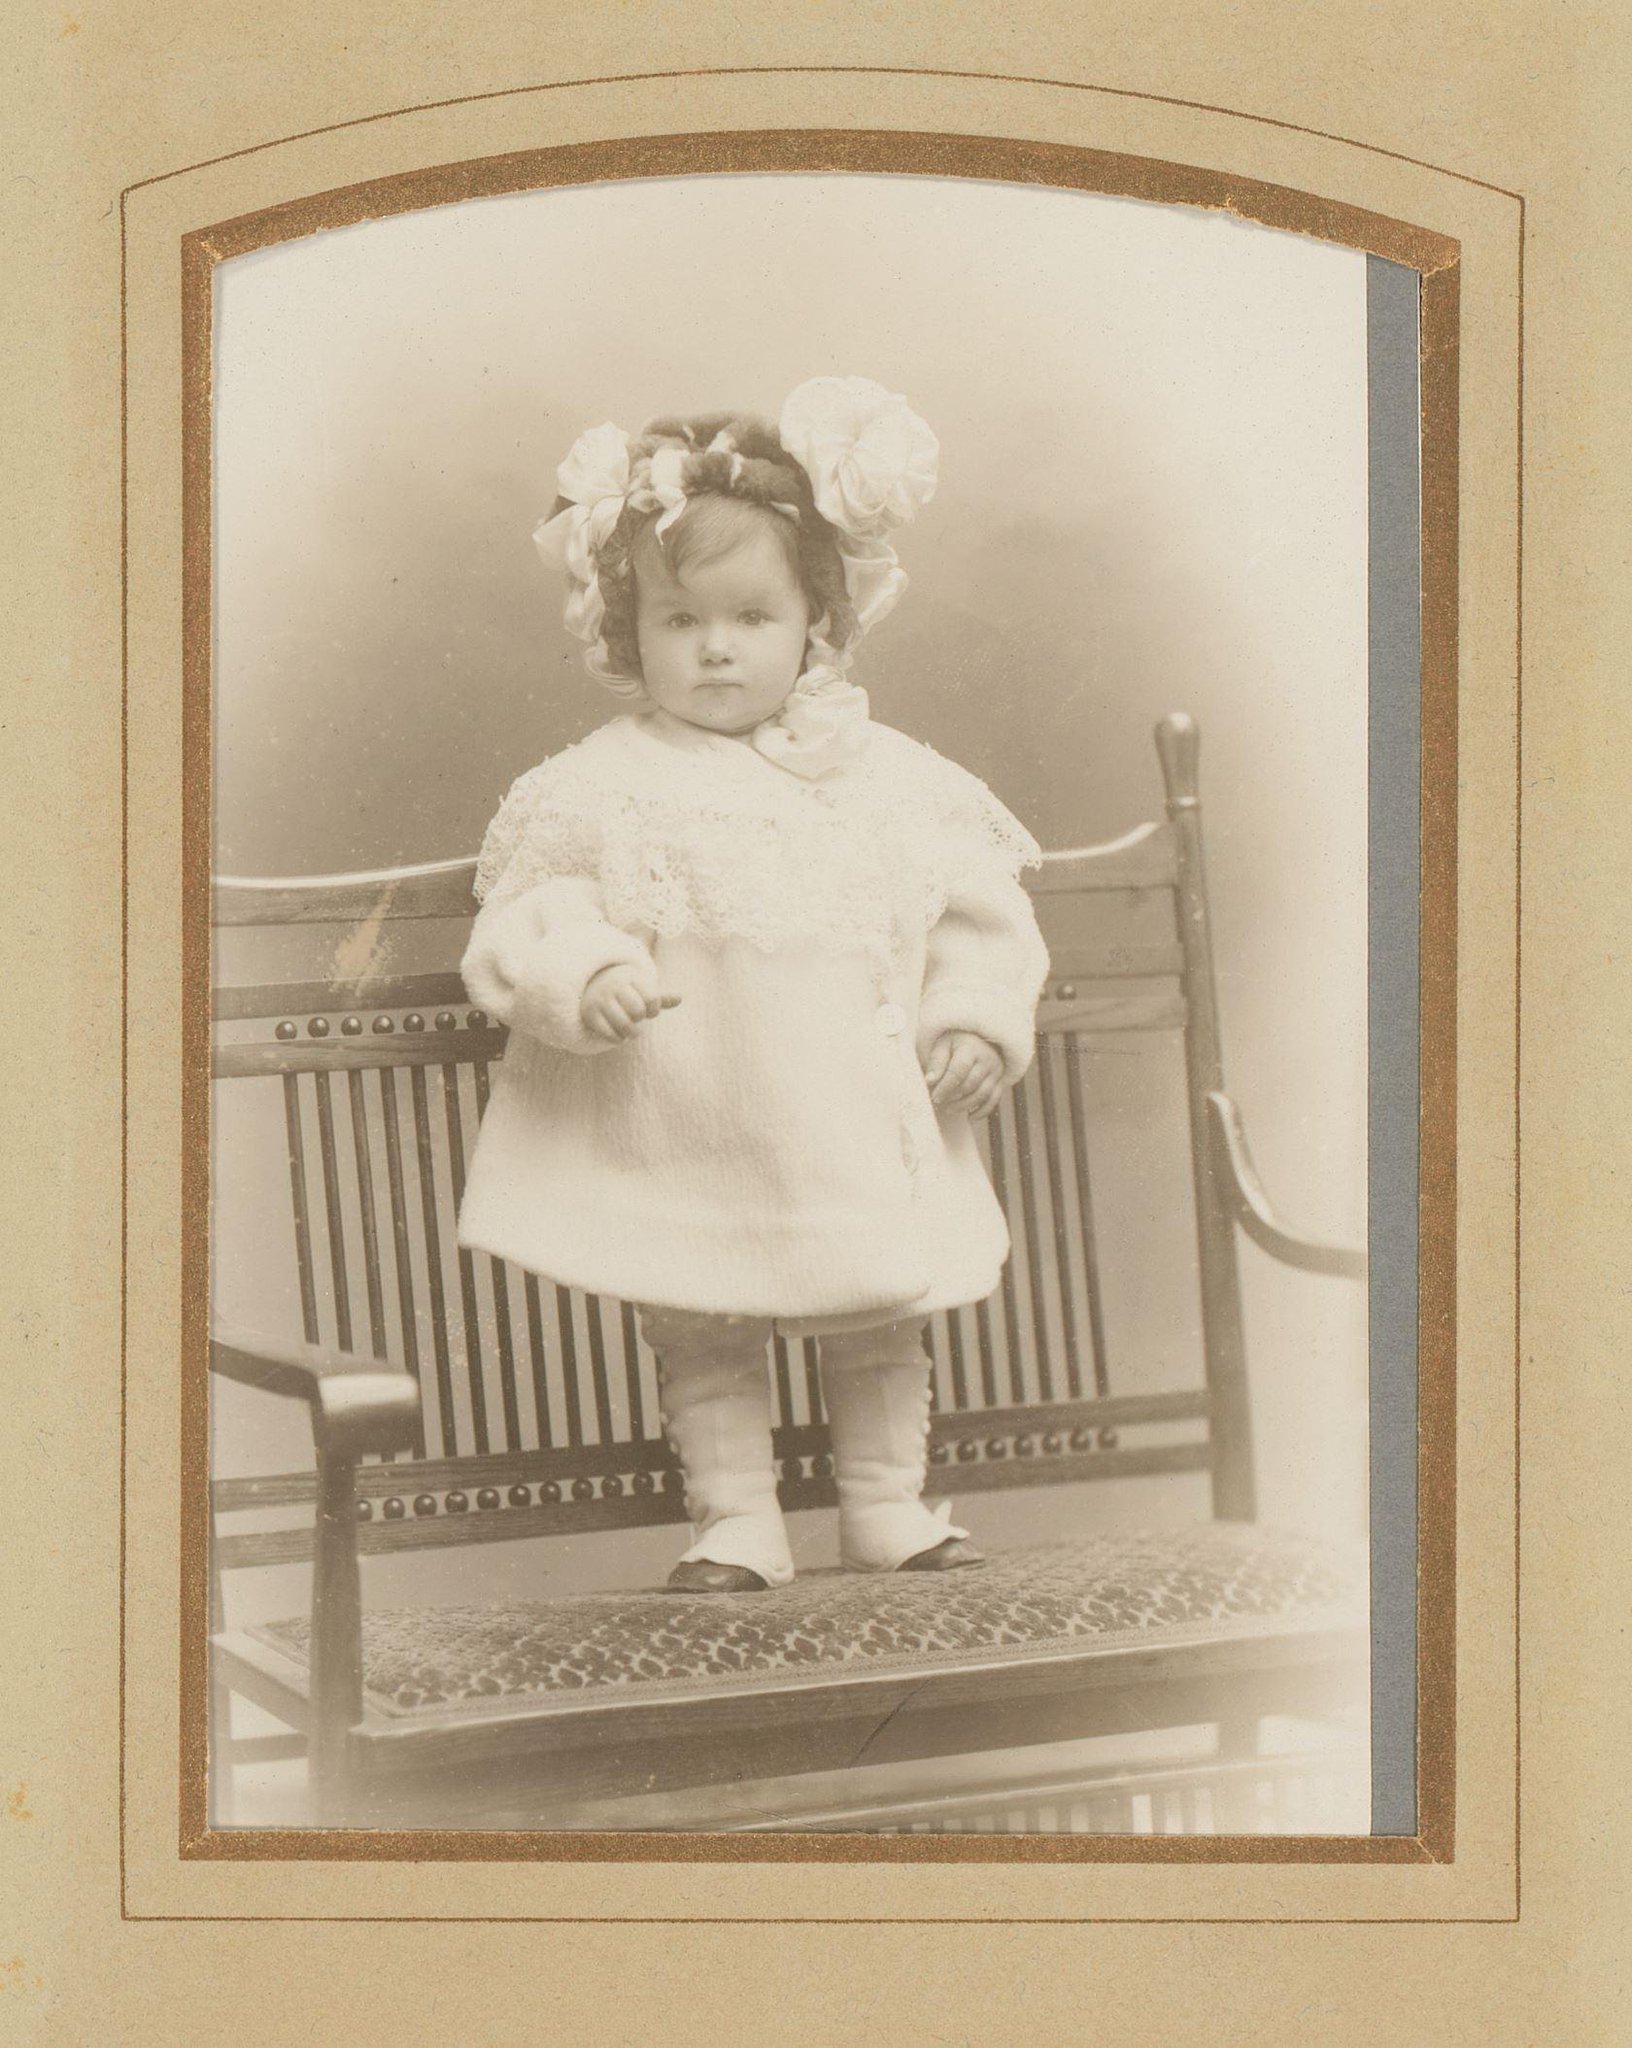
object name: photograph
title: Portret van een staand meisje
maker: max büttinghausen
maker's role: fotograaf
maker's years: 1847-1906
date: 1880-1906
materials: cardboard, photographic support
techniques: collodion silver print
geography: amsterdam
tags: girl (child between toddler and youth)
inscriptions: inscription: ‘Spui 15/ M. Büttinghausen/ Eenig/ Atelier’